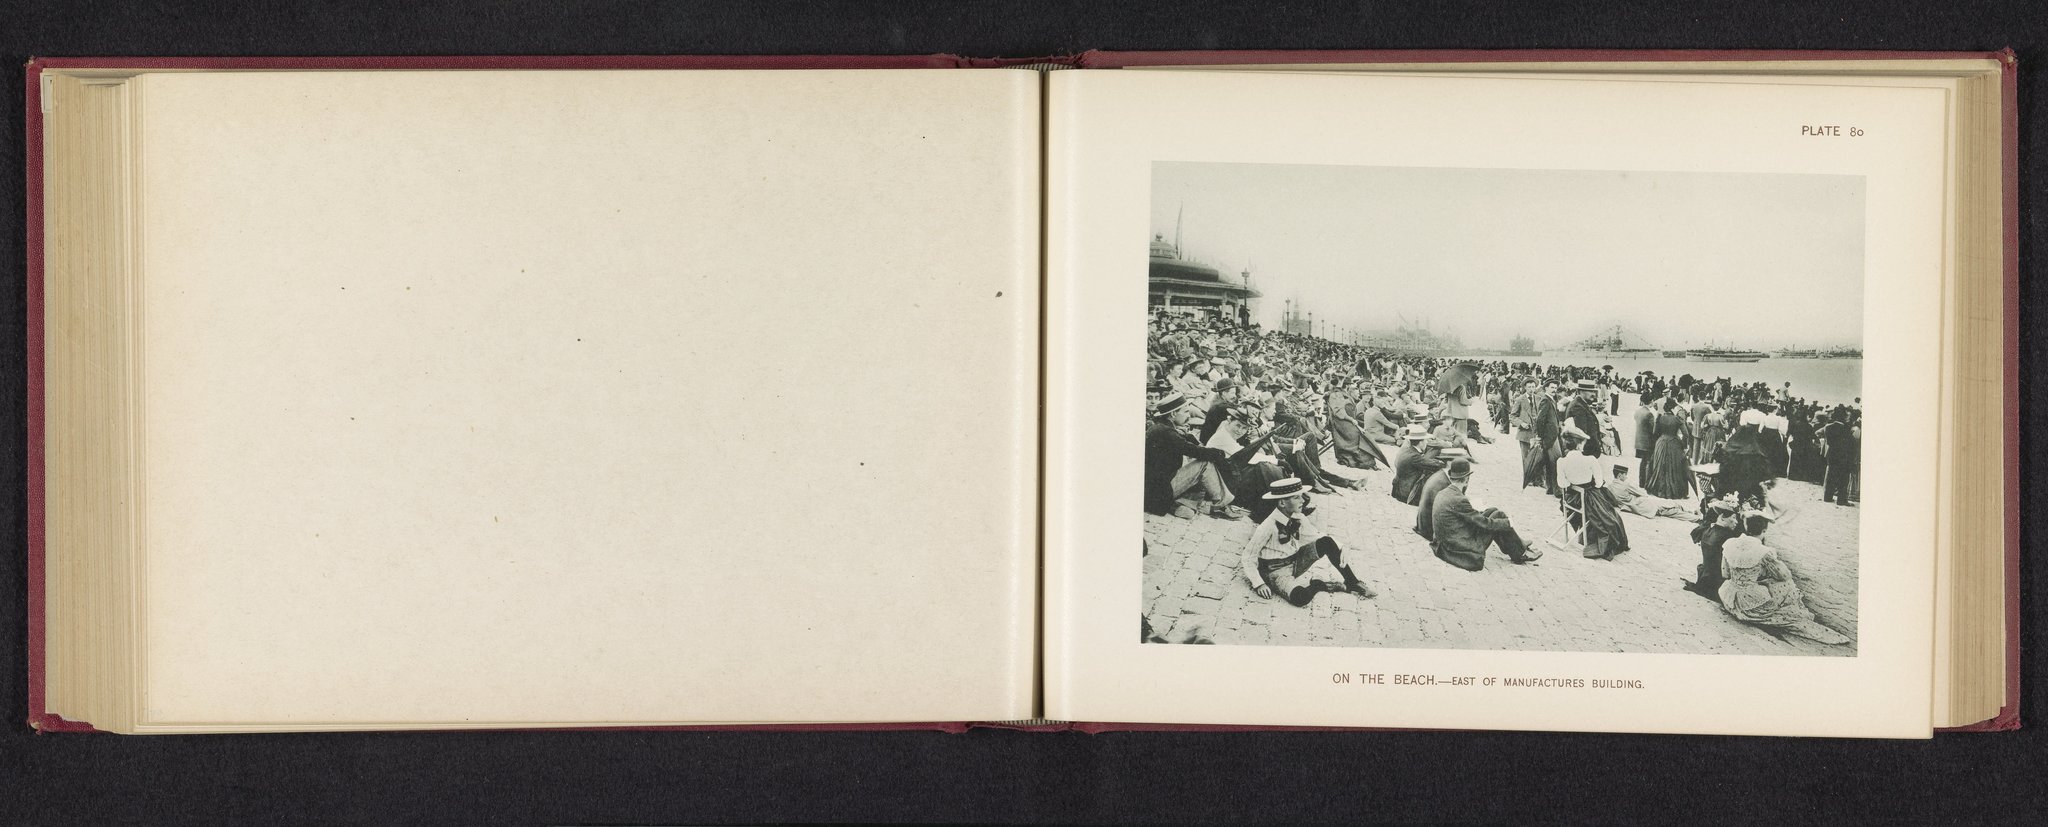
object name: page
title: Mensen bekijken vanaf een kade schepen tijdens de World's Columbian Exposition in Chicago in 1893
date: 1893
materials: paper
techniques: photograph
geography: chicago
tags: world fair, world exhibition, ships (in general), quay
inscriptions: number: ‘Plate 80’